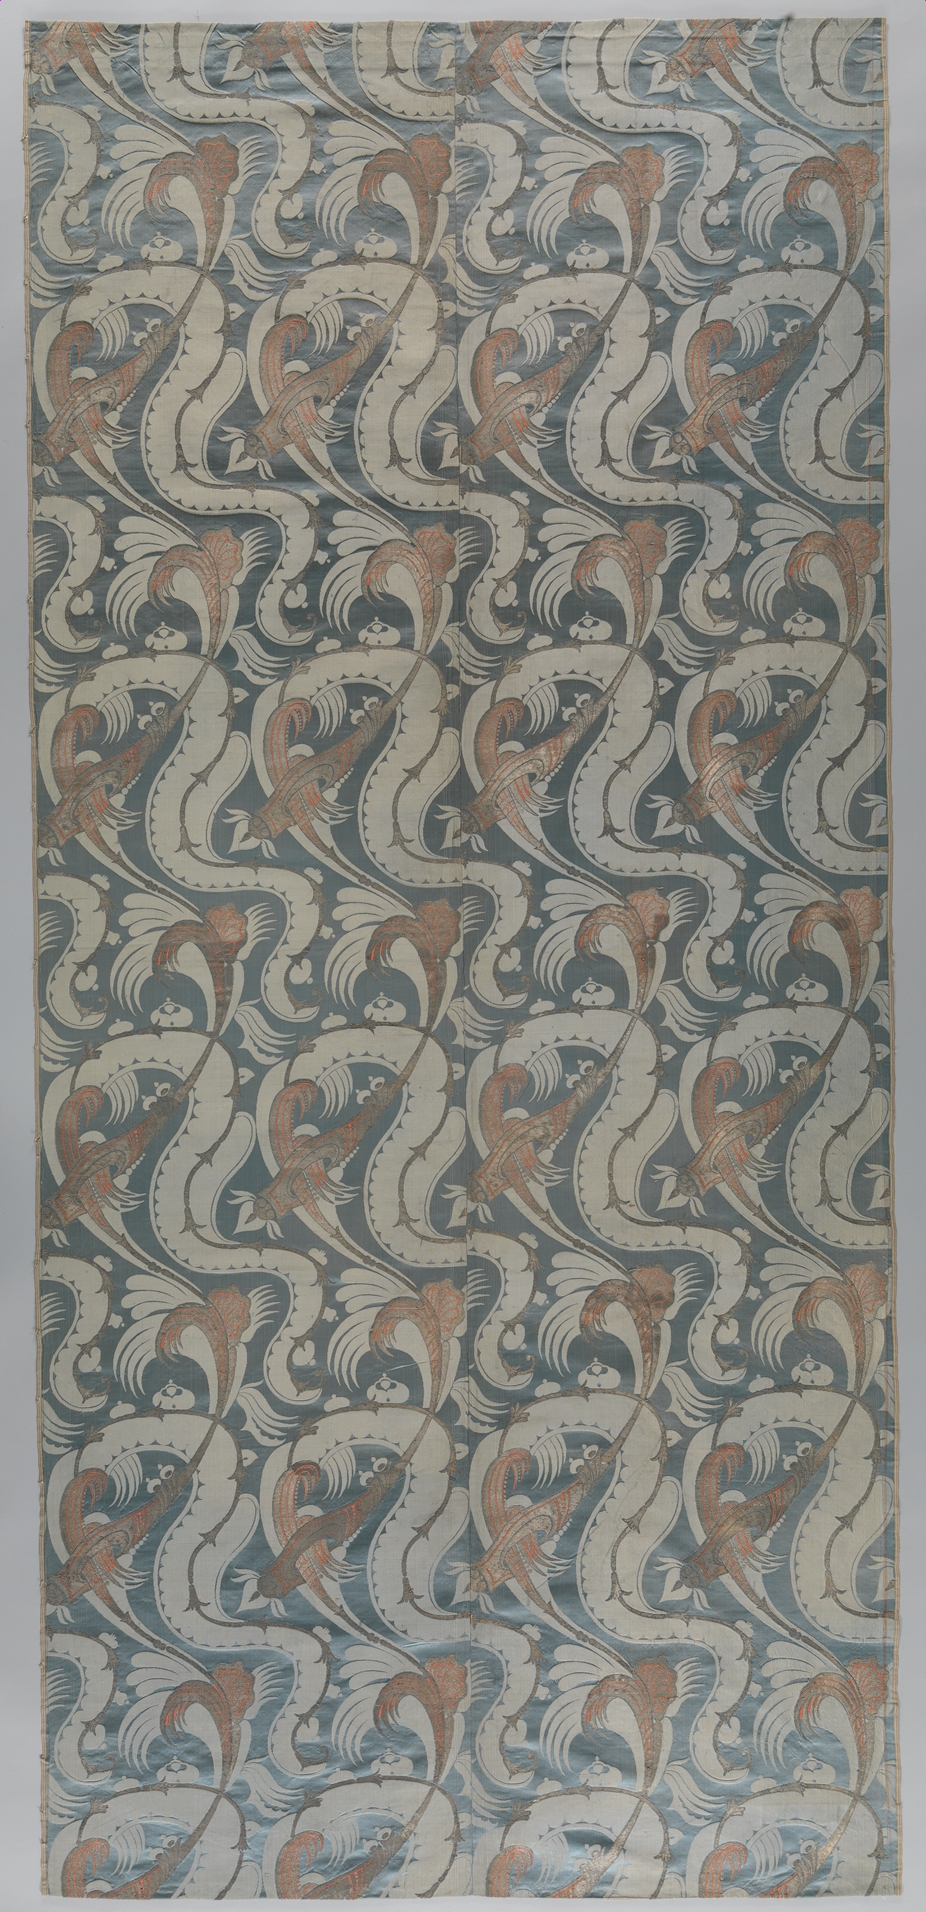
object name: length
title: Length of bizarre silk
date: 1700-1710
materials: metal thread, silk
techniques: brocade